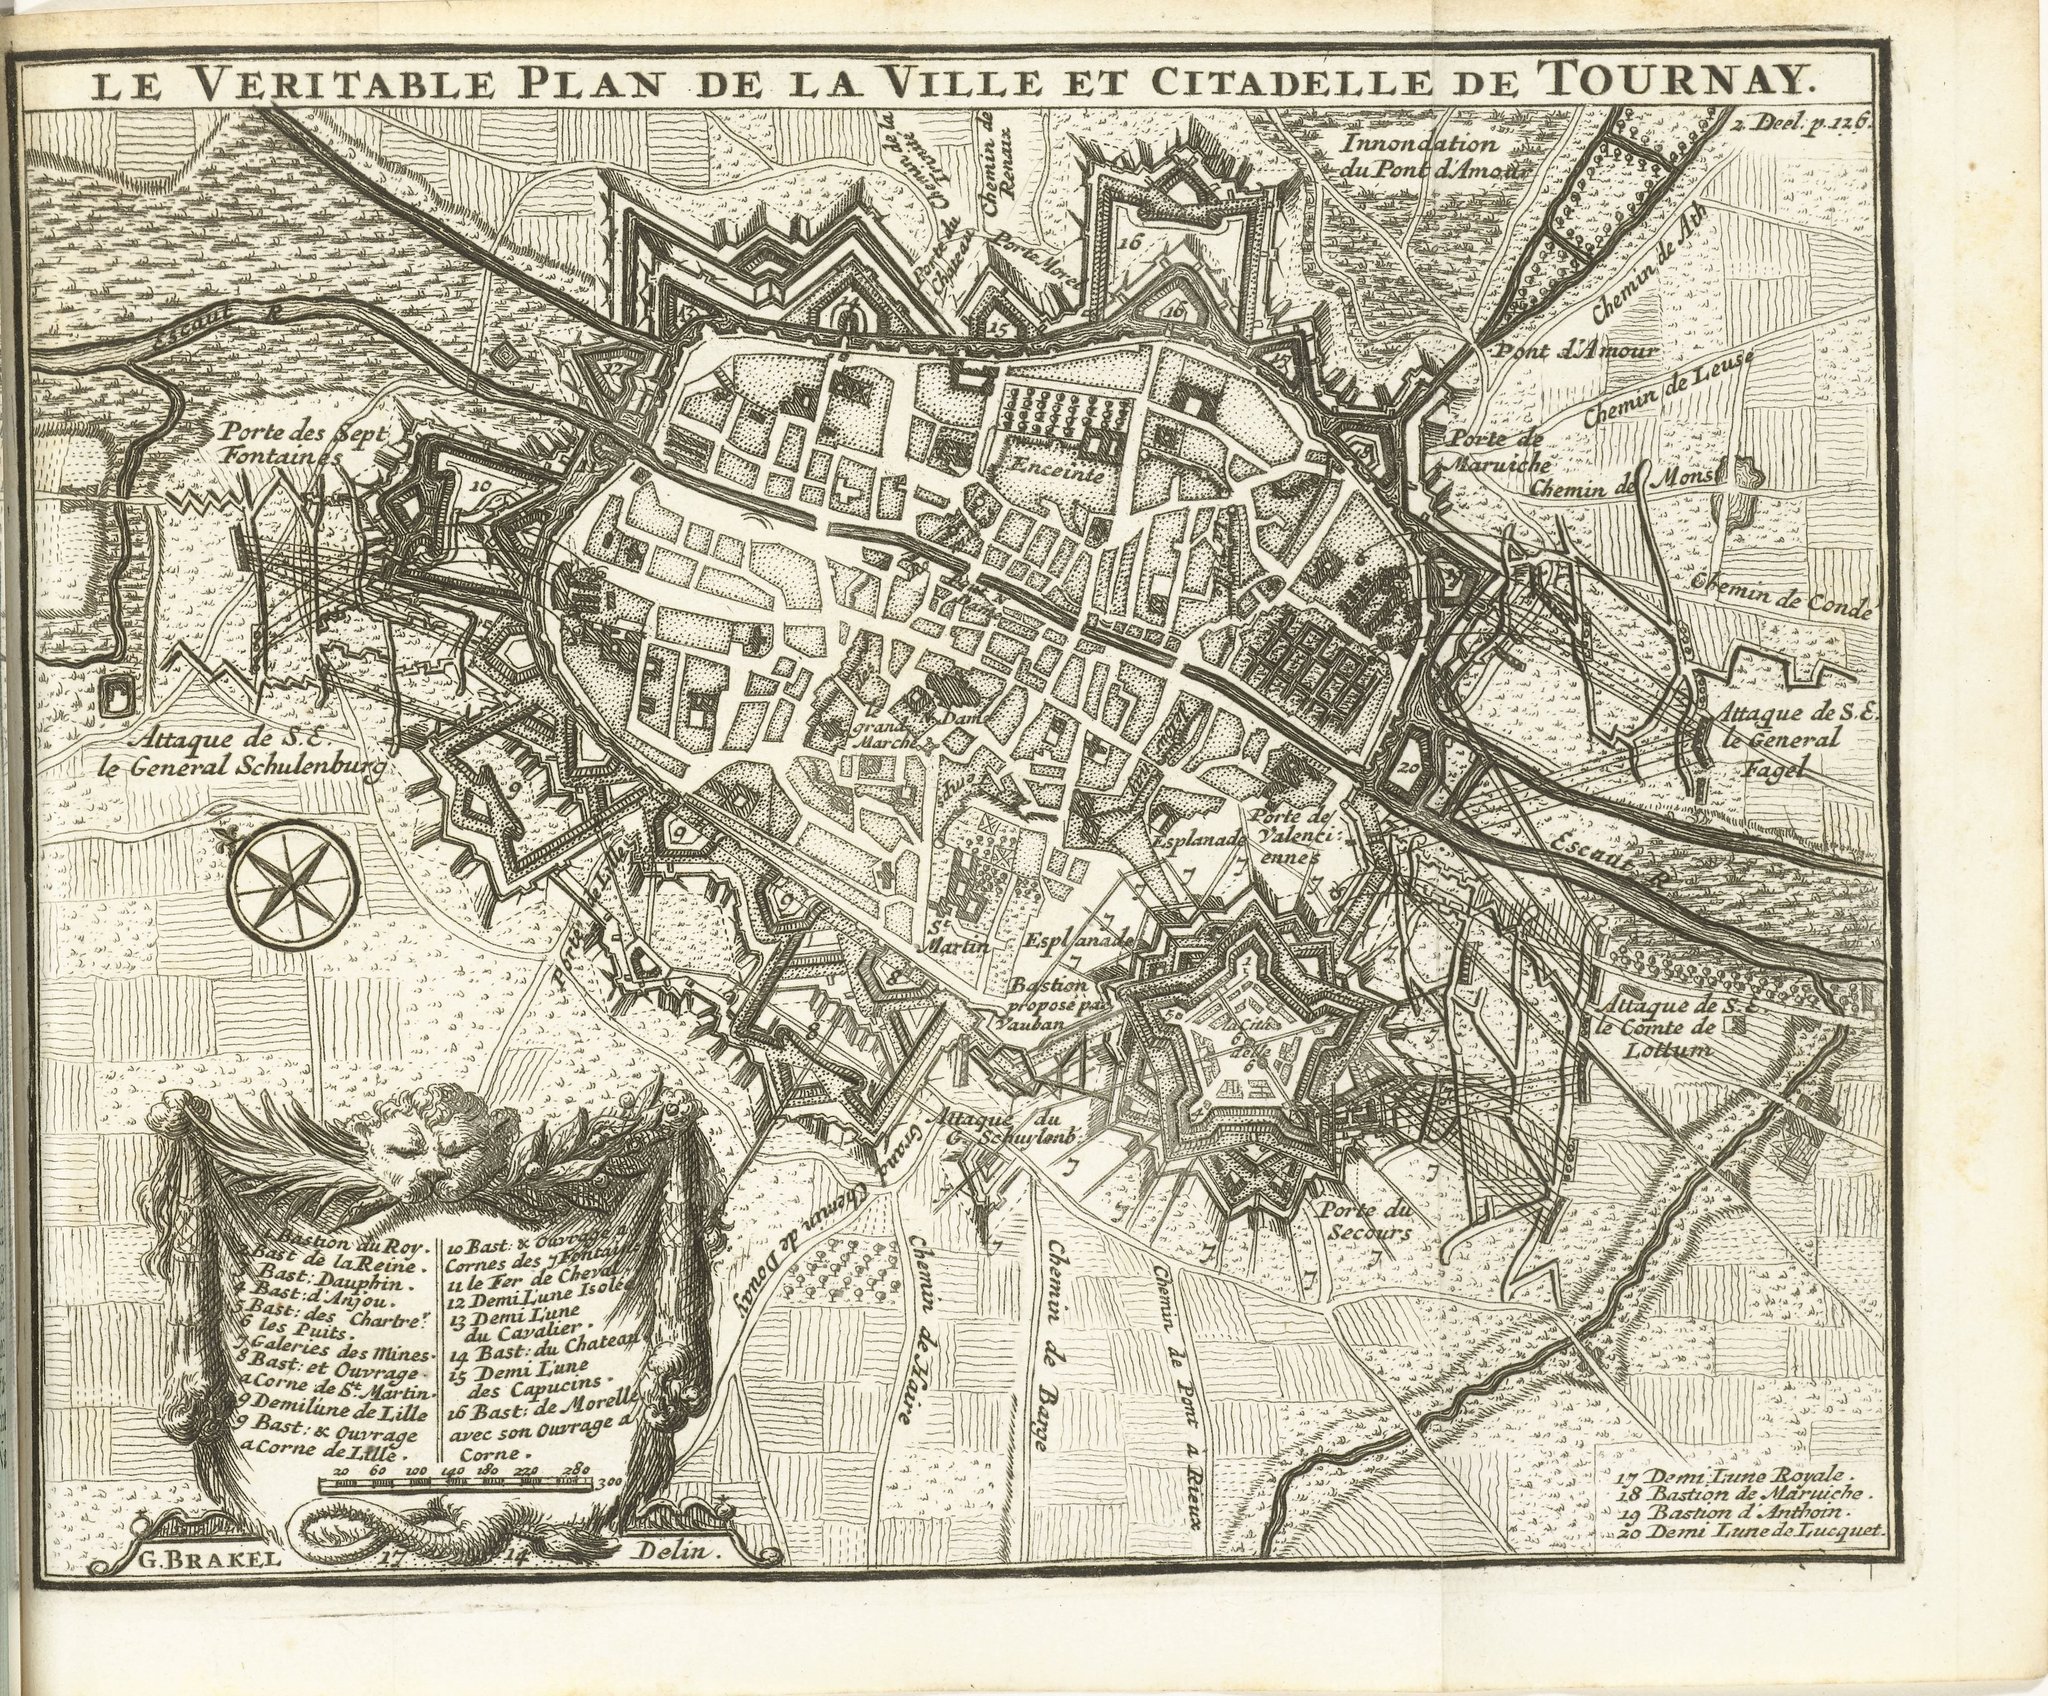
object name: print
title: Le veritable plan de la ville et citadelle de Tournay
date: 1714-1716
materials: paper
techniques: etching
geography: northern netherlands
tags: johan willem friso (prins van oranje-nassau), siege, position war, maps of cities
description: Plattegrond van Tournai (Doornik), belegerd door de geallieerden en ingenomen in 1709. Illustratie in de Nederlandse vertaling uit 1716 van J. Lamigue, Het leven van Zyne Hoogheit Johan Willem Friso, dl. II, p. 126/127.